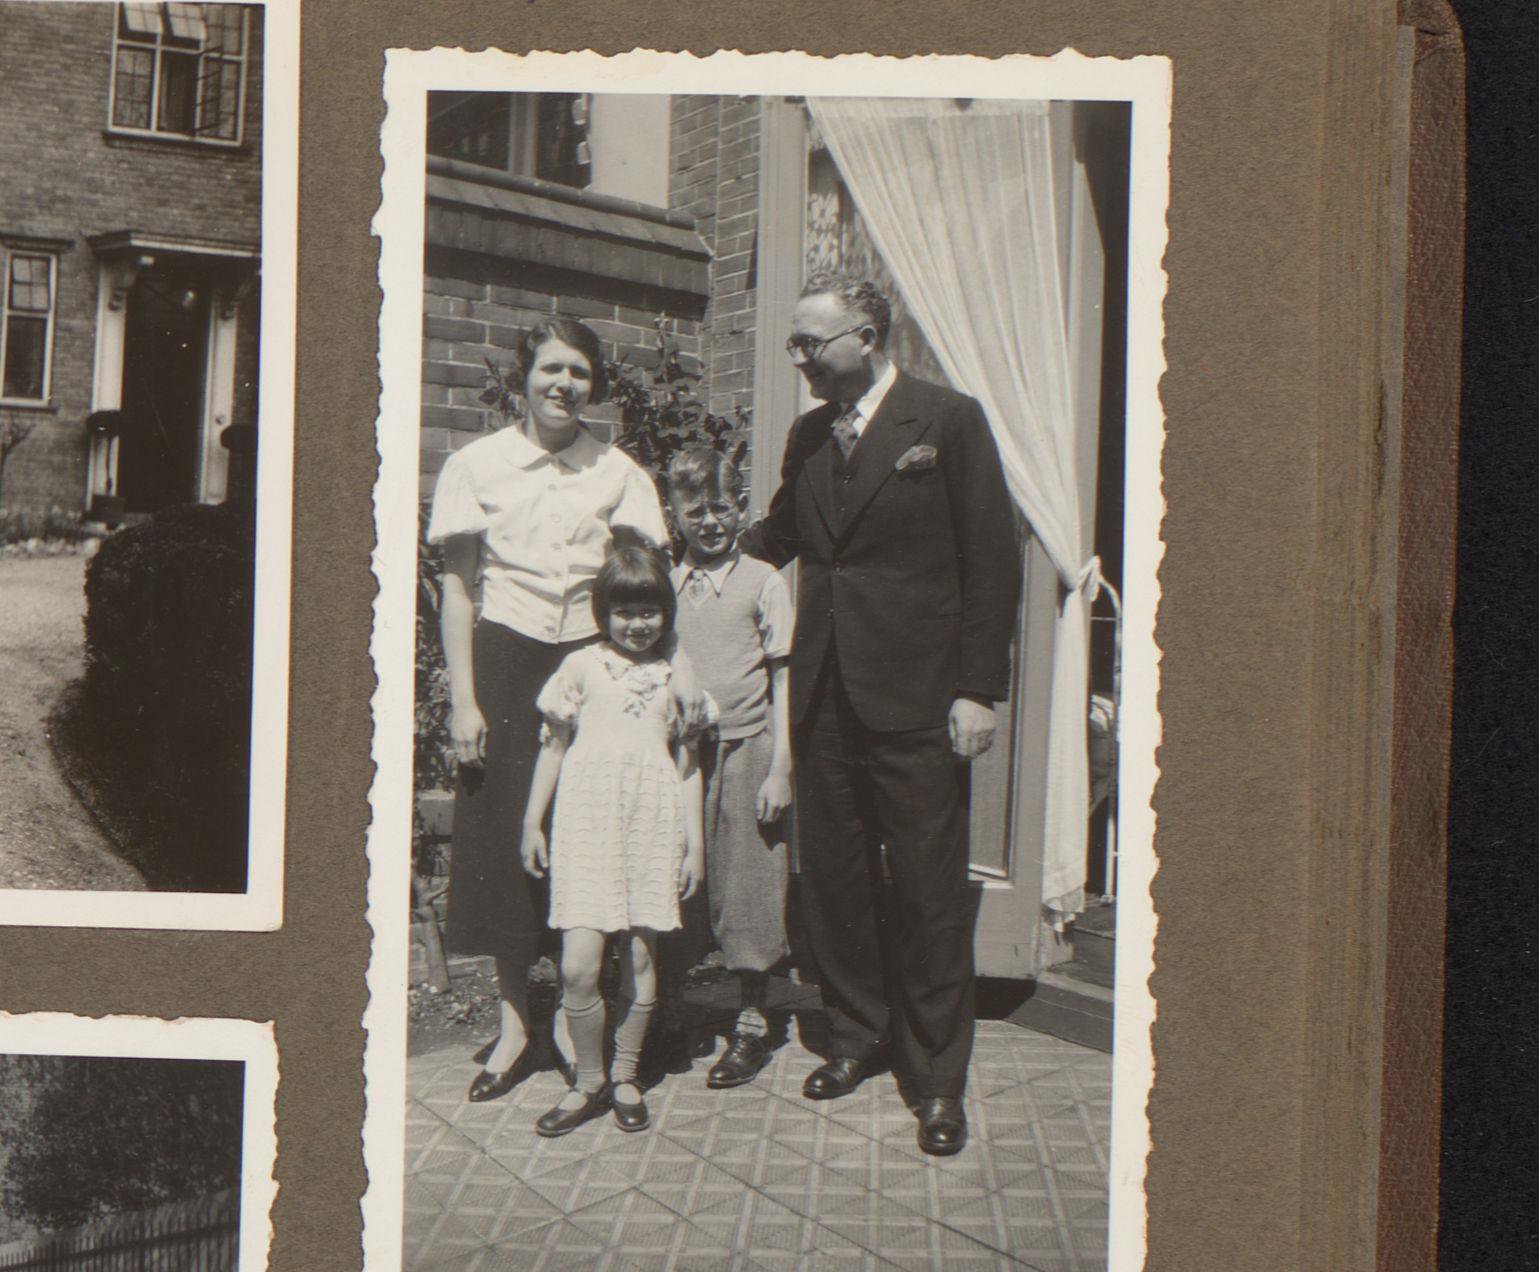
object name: photograph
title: Groepsportret van de familie Bennink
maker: Anonymous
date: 1933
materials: paper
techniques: gelatin silver print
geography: the hague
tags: family group, especially parents with their child(ren), anonymous historical persons portrayed in a group, in a group-portrait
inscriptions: inscription: ‘fam. Bennink’